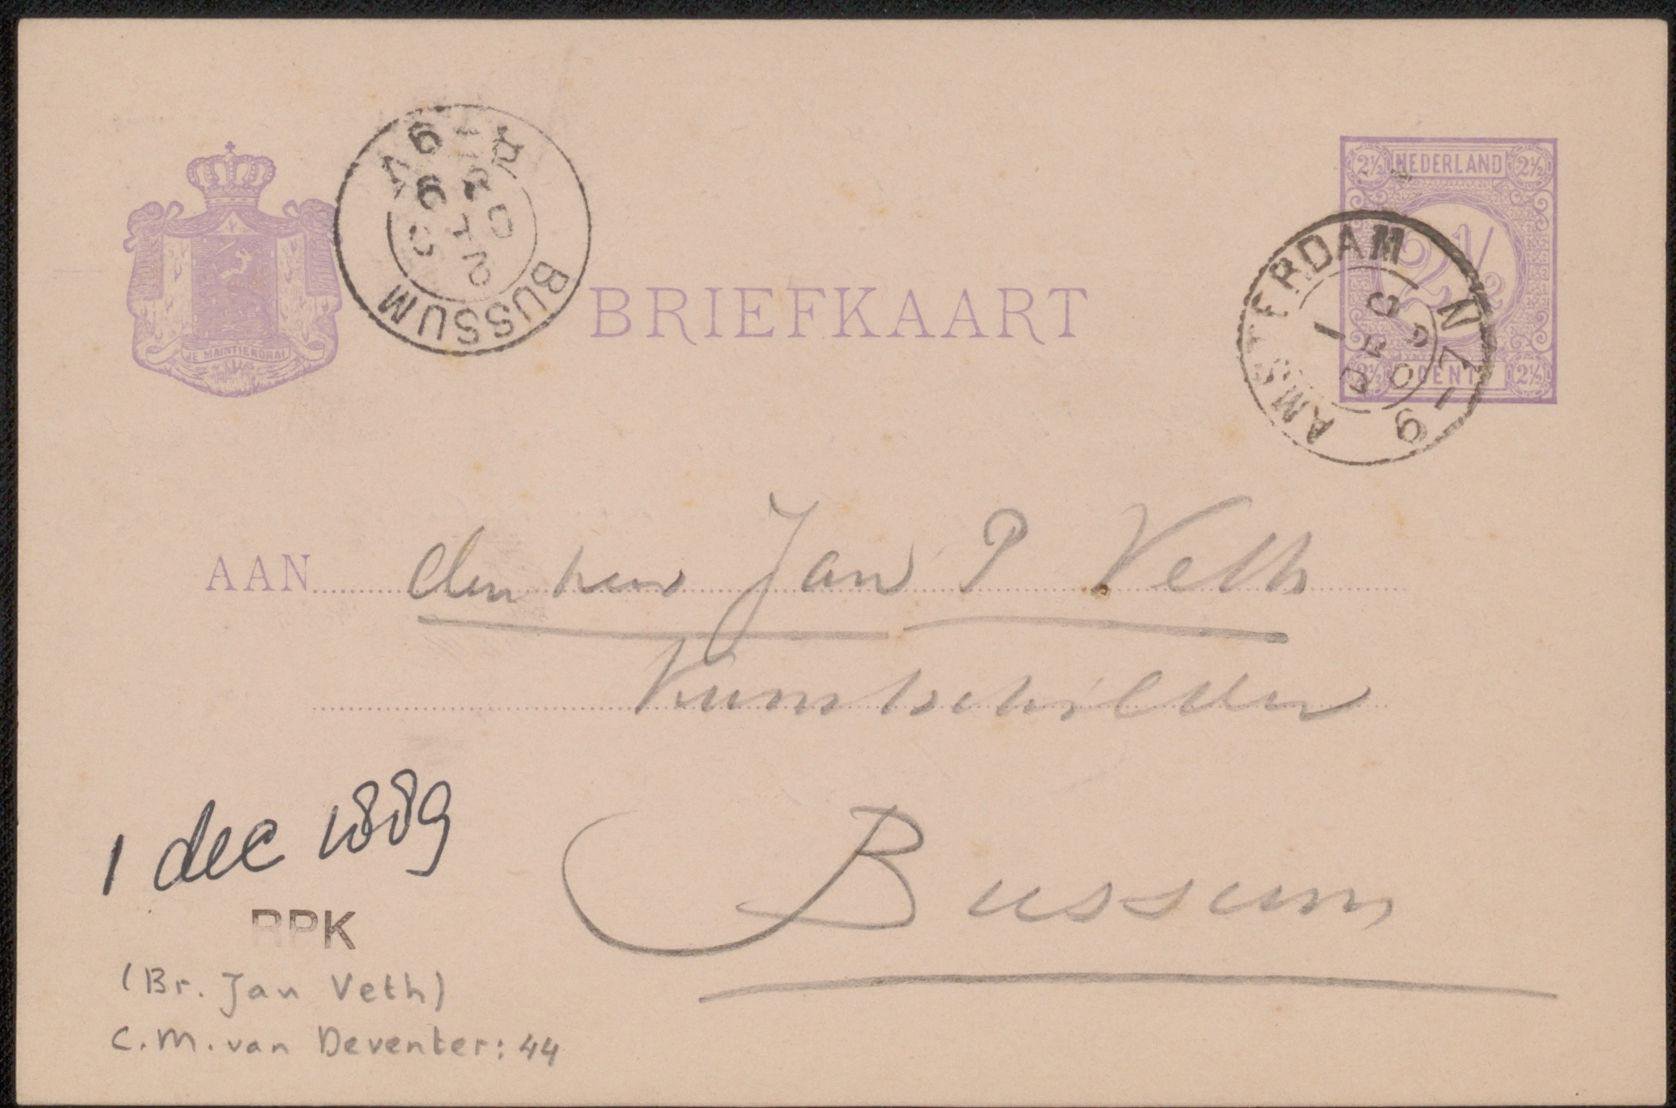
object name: postcard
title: Briefkaart aan Jan Veth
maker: chap van deventer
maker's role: kunstcriticus, scheikundige, schrijver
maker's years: 1860-1931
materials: cardboard, pencil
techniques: writing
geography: amsterdam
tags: painter, print maker, draughtsman, jan veth, artist, anna dorothea dirks, family life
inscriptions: collector's mark: ‘RPK’